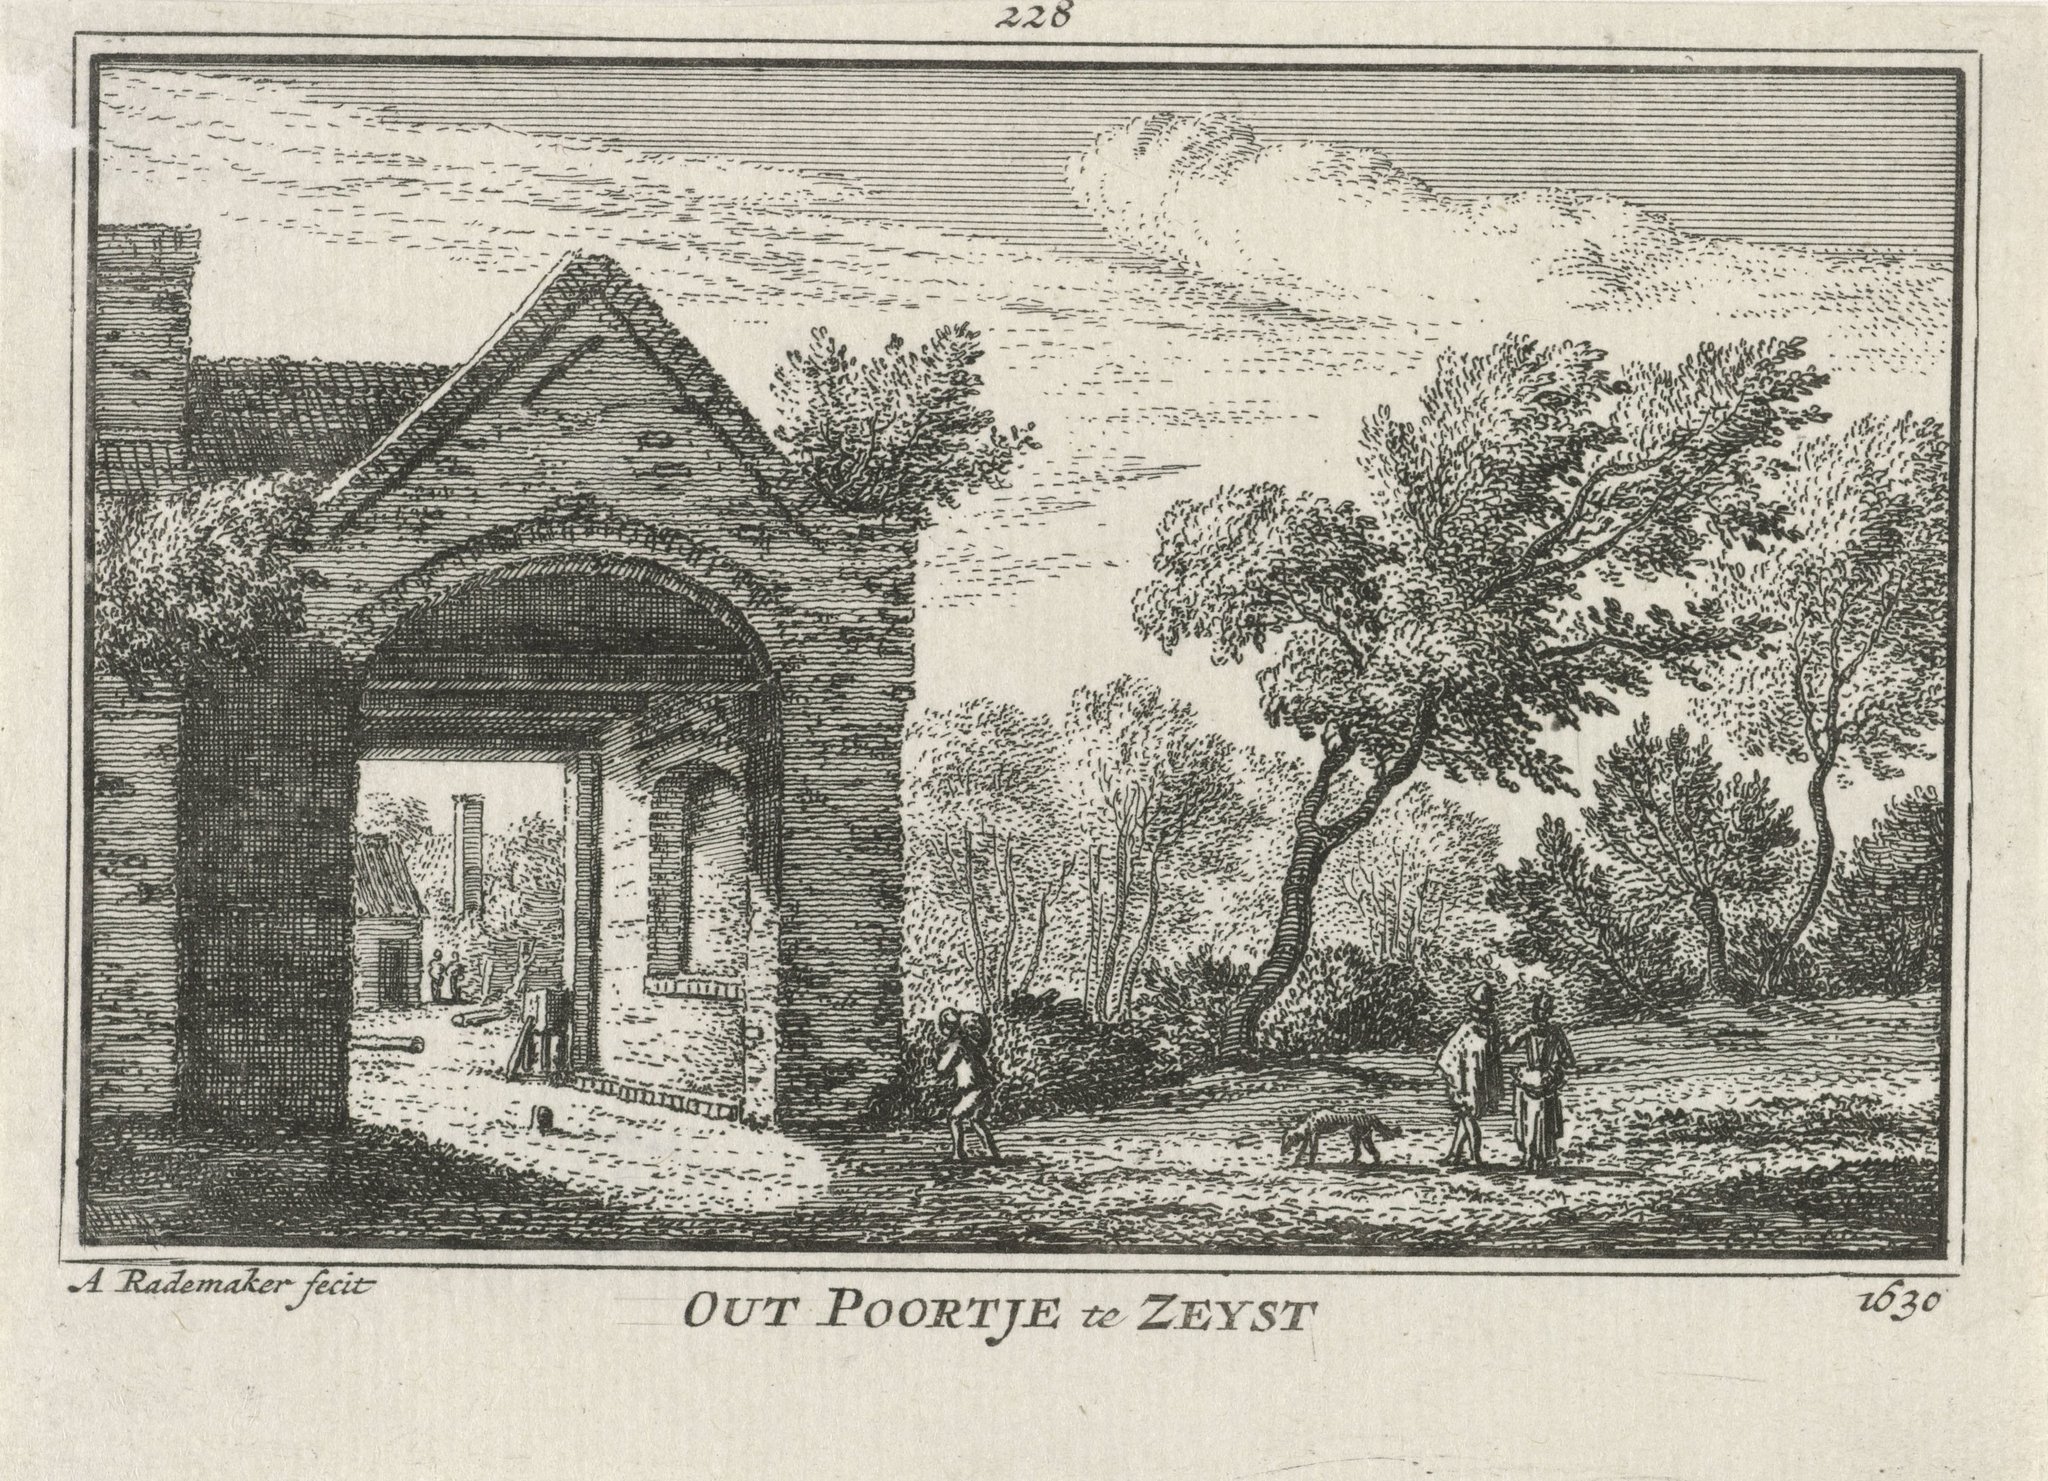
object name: book illustration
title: Gezicht op een oude poort in Zeist, 1630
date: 1727-1733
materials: paper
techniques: engraving, etching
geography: amsterdam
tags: gate, entrance, dog, zeist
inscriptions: collector's mark: Lugt 2228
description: Illustratie uit: Abraham Rademaker, Matthaeus Brouërius van Niedek, Isaac Le Long, Kabinet van Nederlandsche en Kleefsche outheden en (...) voorname stads- en landgebouwen, Willem Barents en Antoni Schoonenburg: Amsterdam, 1727-1733, ill. nr. 228.